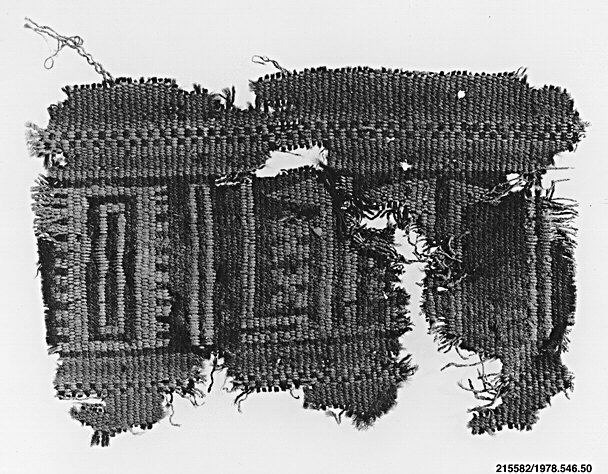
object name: band fragment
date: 1001-1200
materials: cotton, wool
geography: egypt